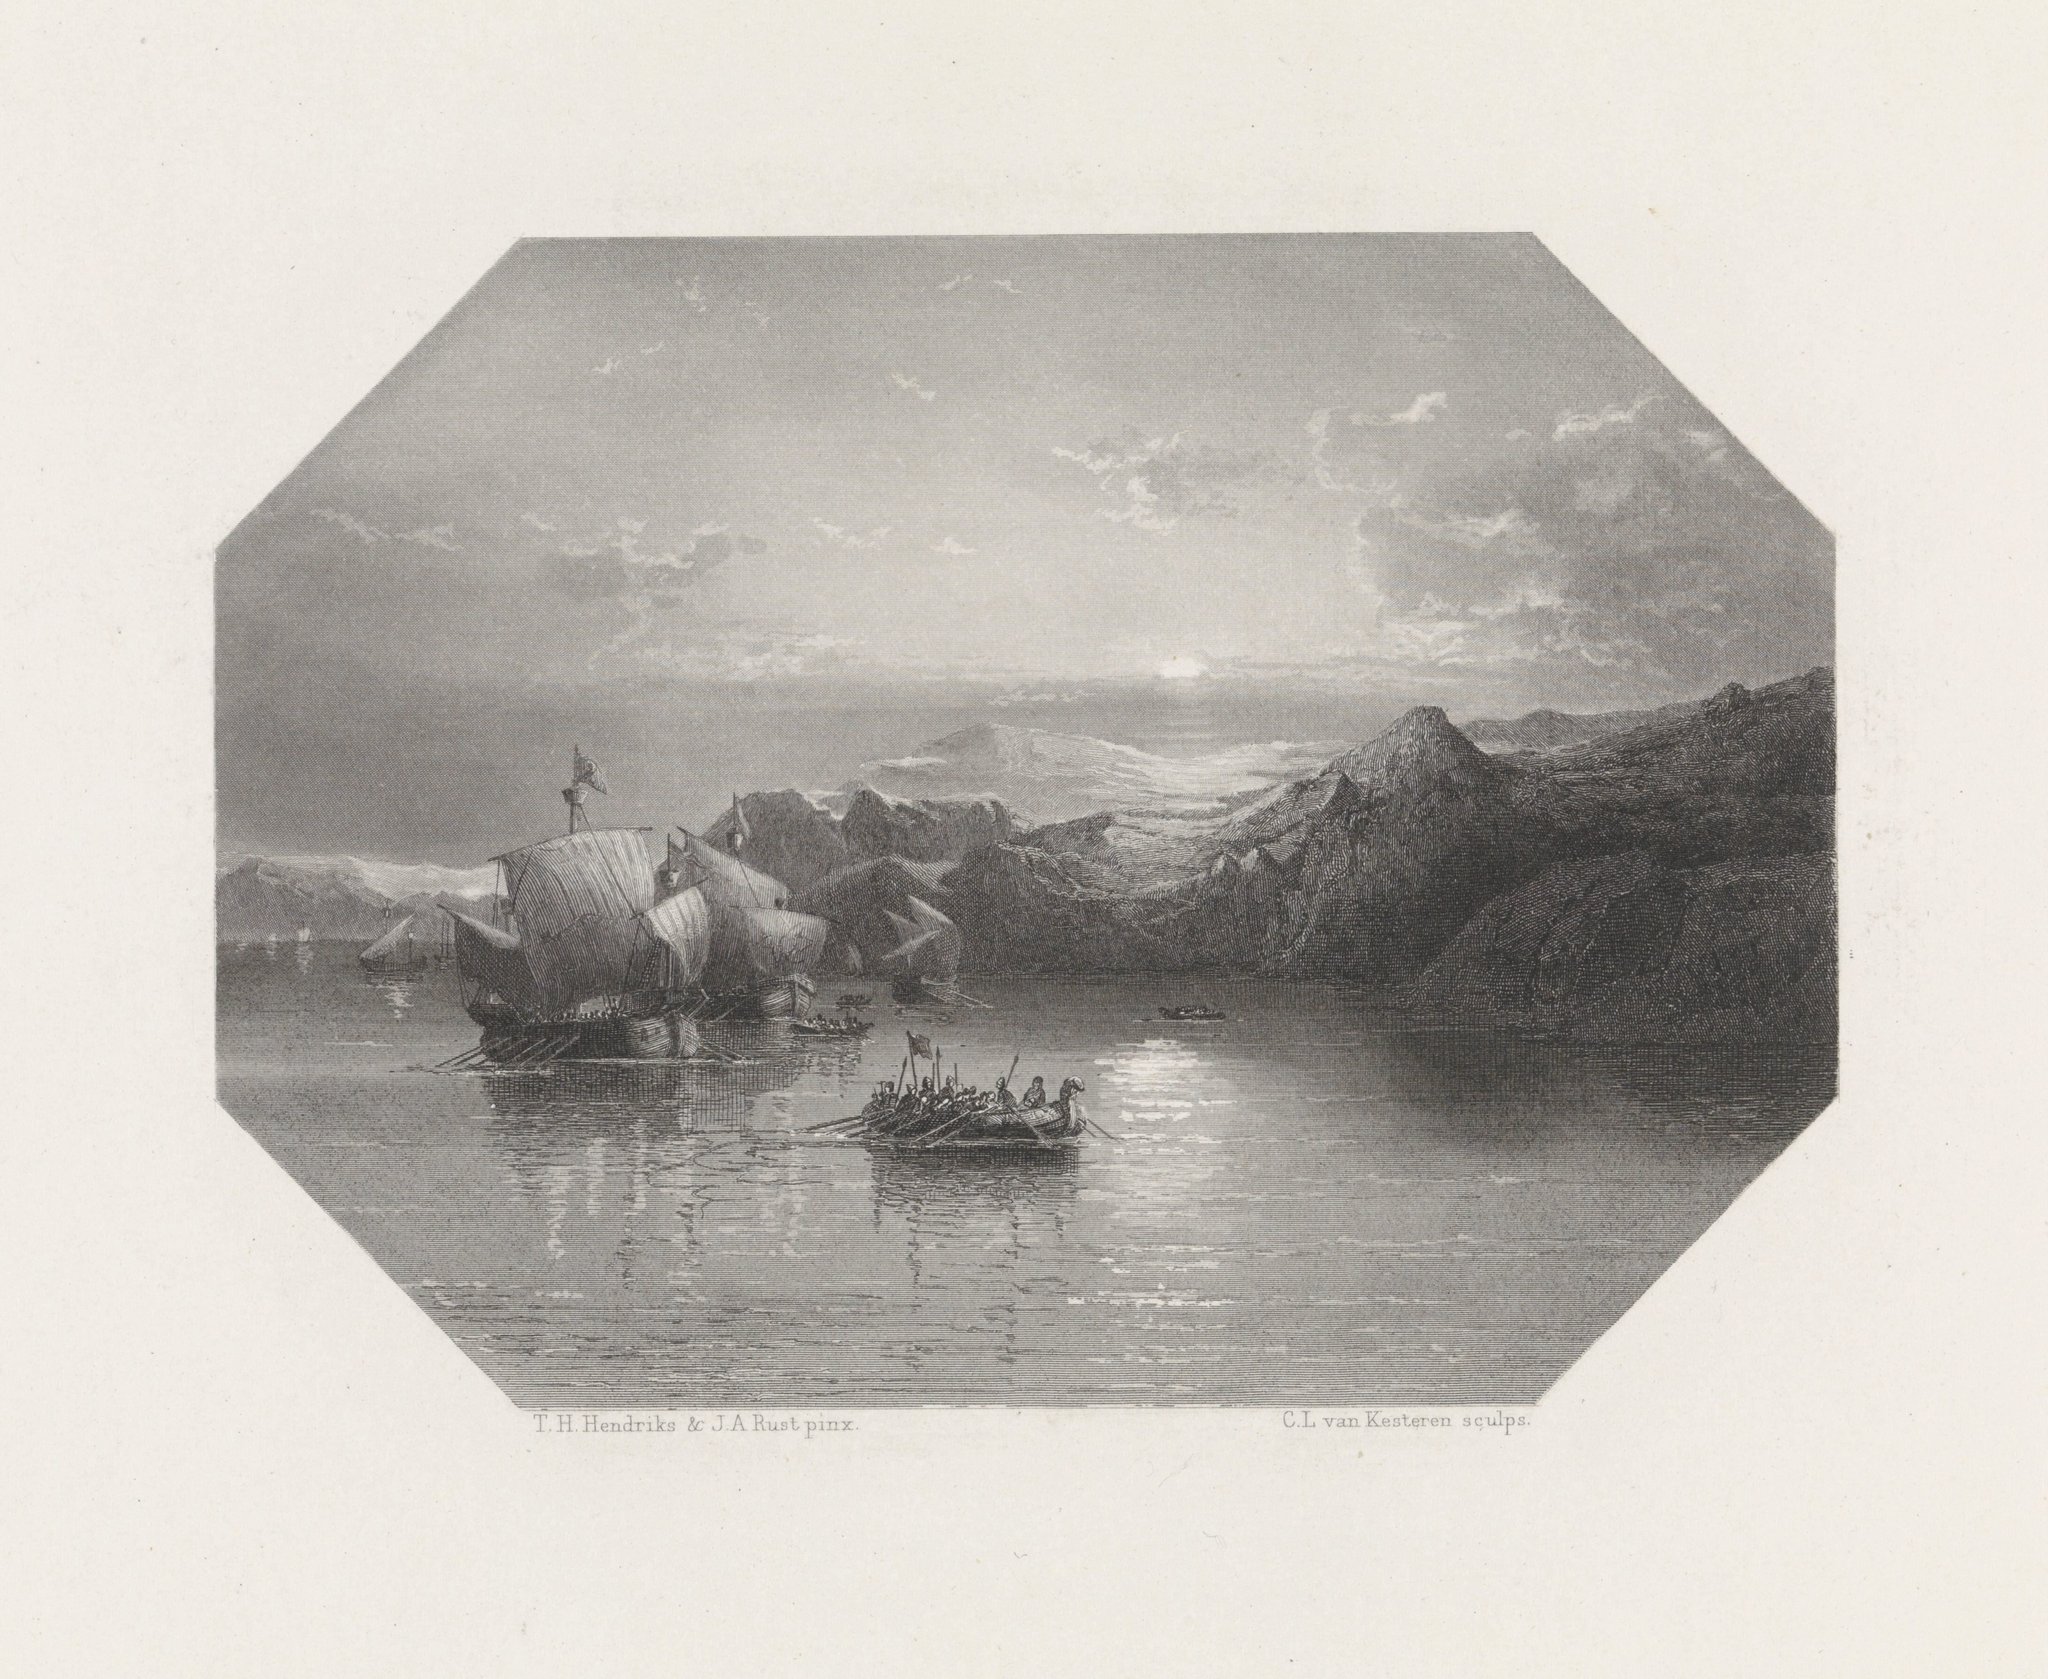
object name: print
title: Friese schepen op ontdekkingsreis, ca. 1038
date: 1865-1870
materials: paper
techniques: engraving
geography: netherlands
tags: exploration, expedition, voyage of discovery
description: Illustratie voor: J. van Lennep en W. Moll en J. ter Gouw, Nederlands geschiedenis en volksleven in schetsen, A.W. Sijthoff, Leiden ca. 1870. Staalgravures naar de schilderijen van de Historische Galerij der Maatschappij Arti en Amicitiae.